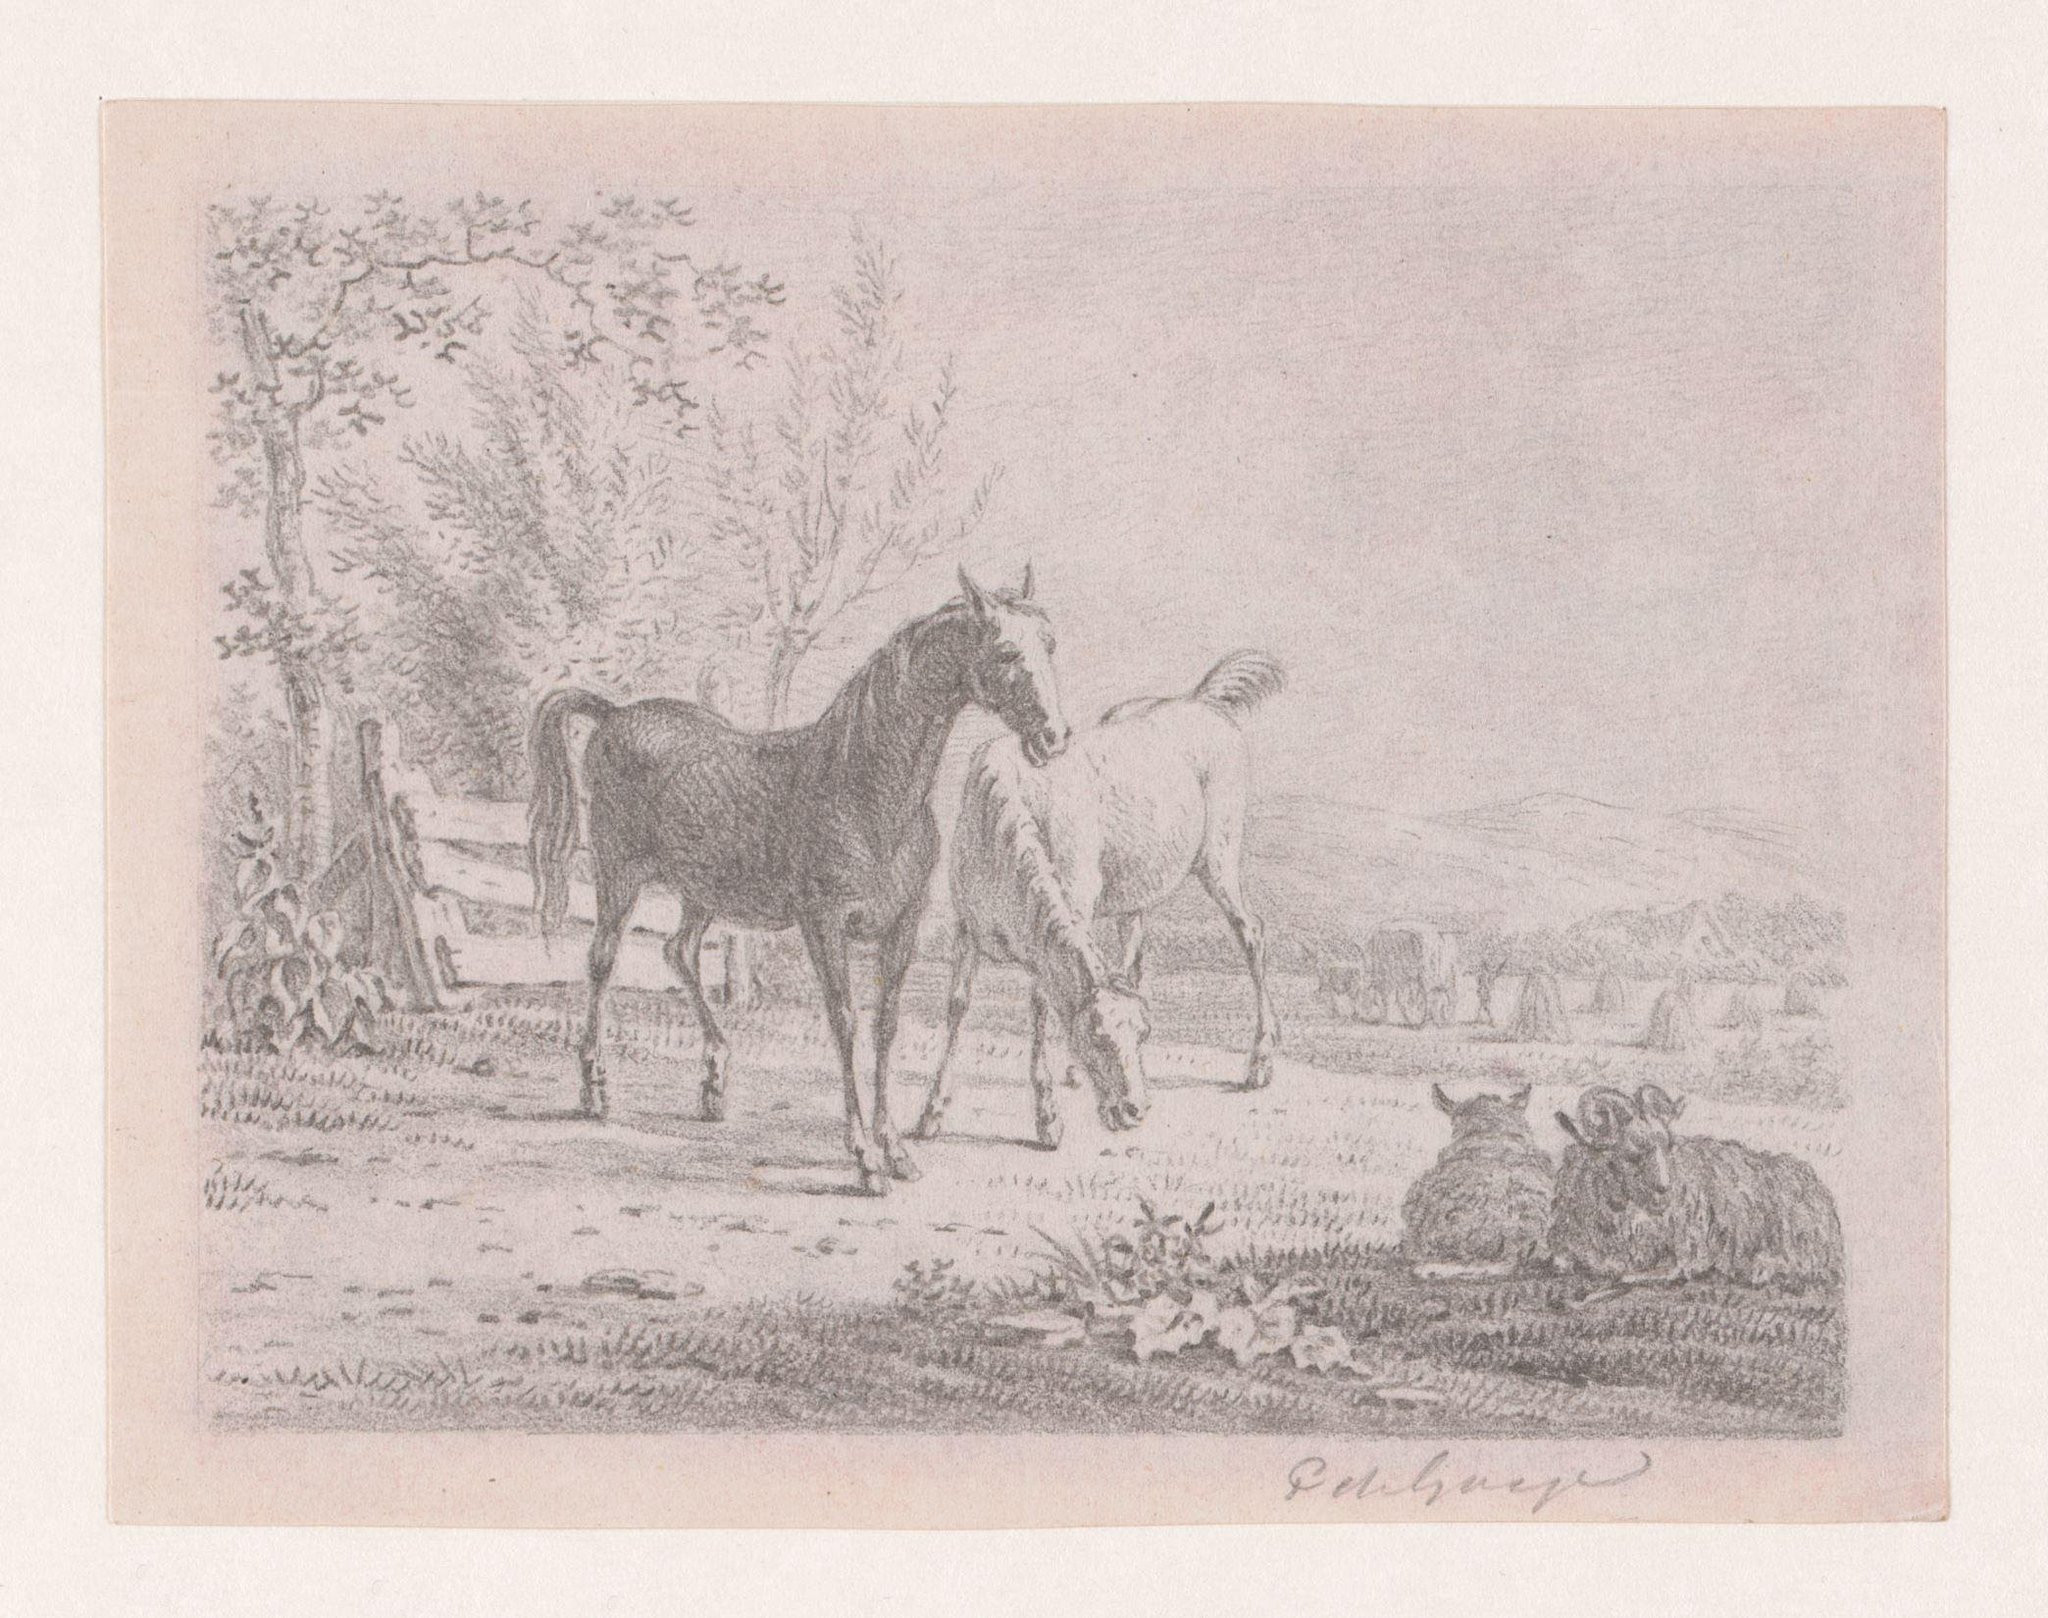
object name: drawing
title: Twee paarden en twee schapen in een weide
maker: pieter de goeje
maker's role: draughtsman, print maker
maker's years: 1789-1859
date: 1809-1859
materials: paper, pencil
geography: netherlands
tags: agricultural products and by-products: hay (+ harvesting ~ agricultural processes), meadow, pasture, sheep, horse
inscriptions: collector's mark: Lugt 2228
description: De schapen liggen op de grond. In de achtergrond staan hooiruiters en een paard en wagen.